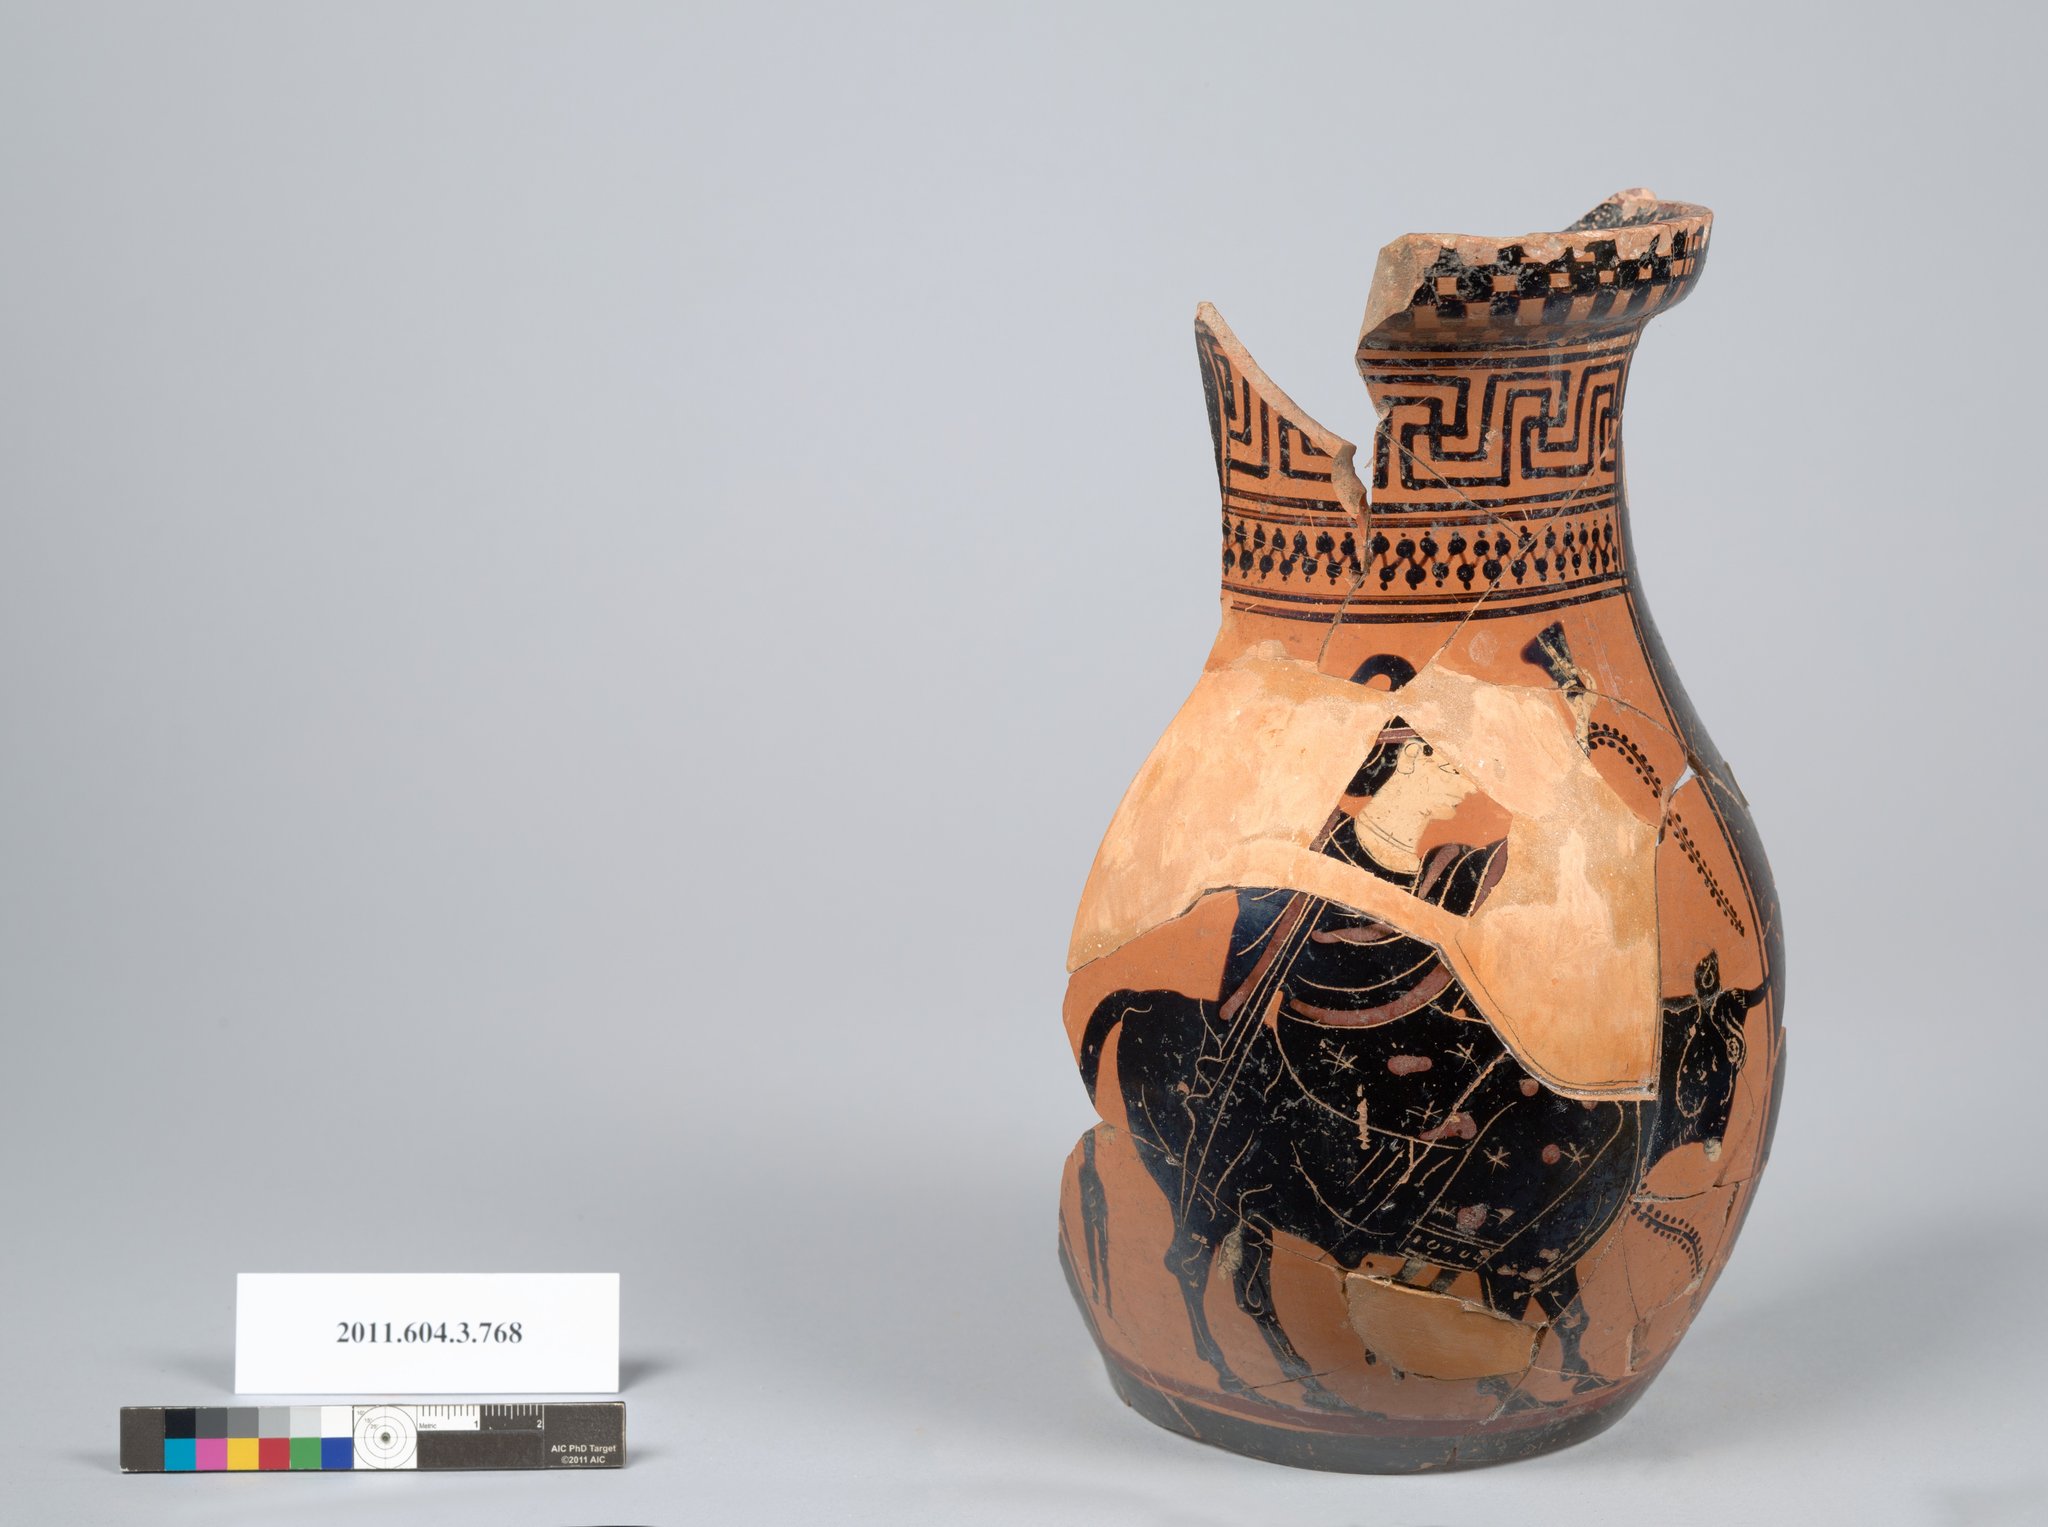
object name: olpe fragment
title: Terracotta fragment of an oinochoe: olpe (jug)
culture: greek, attic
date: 550-526 BCE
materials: terracotta